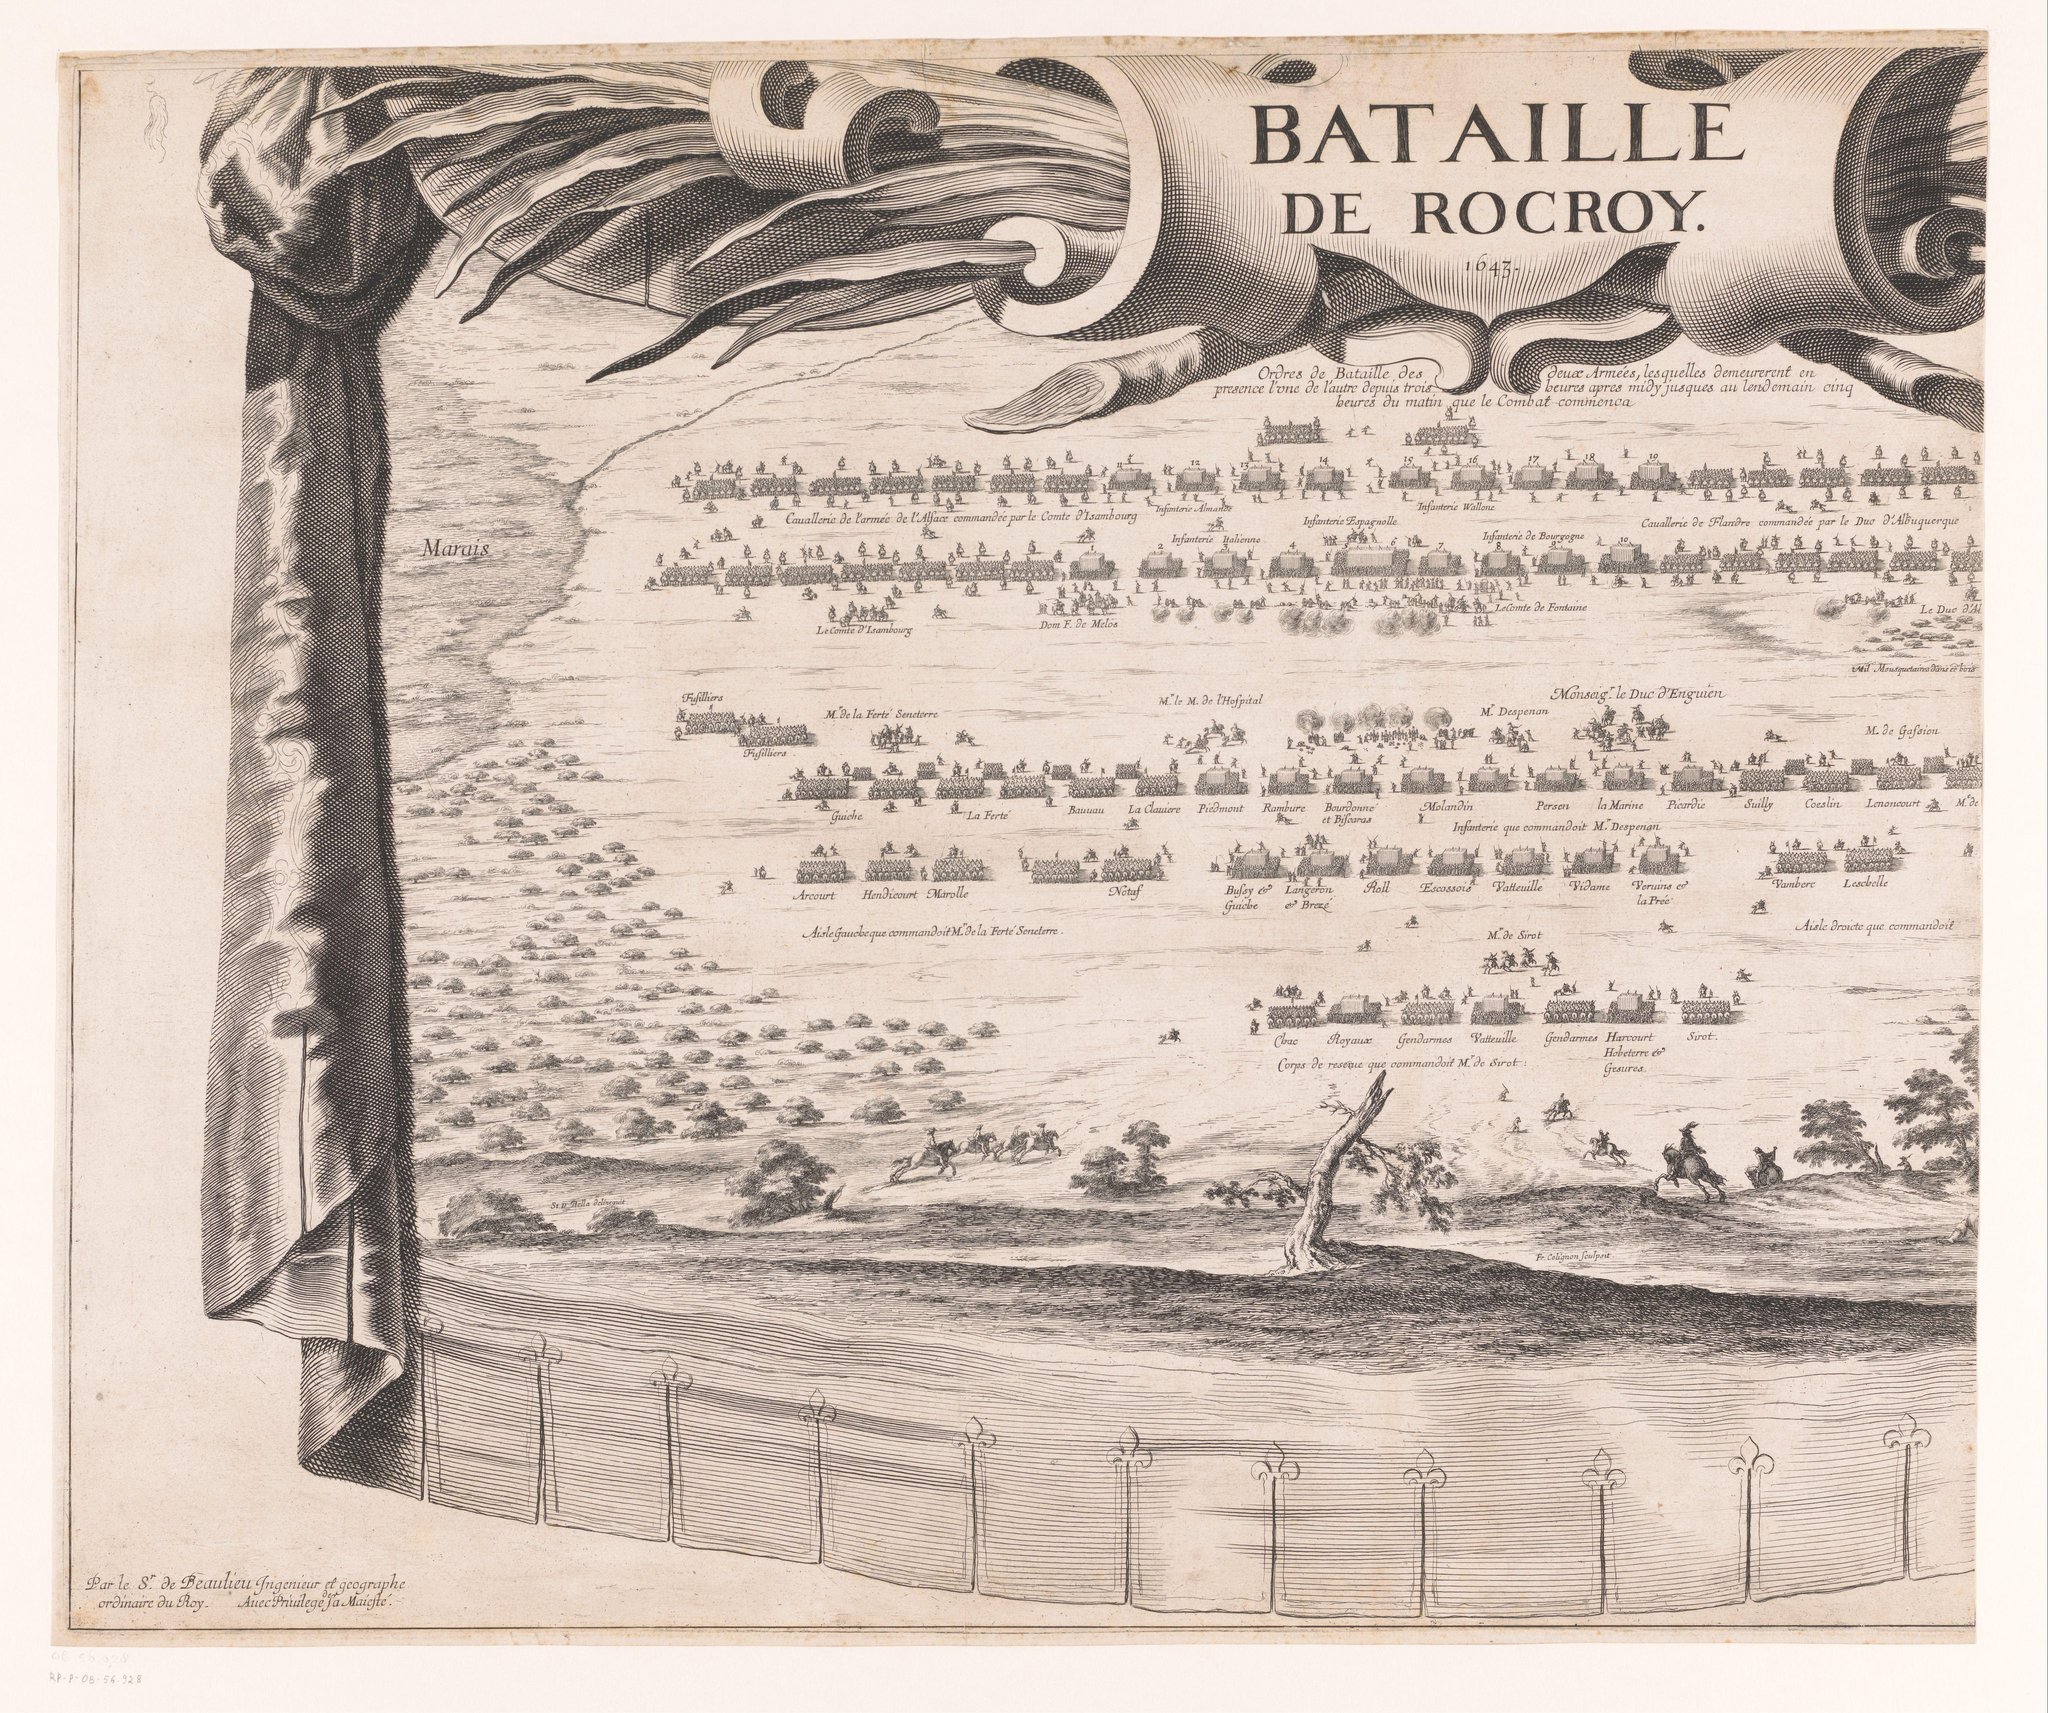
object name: print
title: Bataille de Rocroi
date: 1643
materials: paper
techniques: engraving, etching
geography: france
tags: battle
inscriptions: collector's mark: Lugt 240